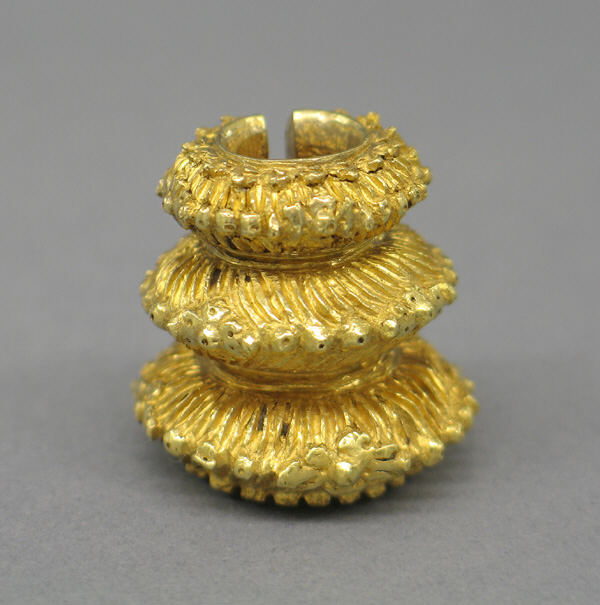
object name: fastener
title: Weighted Fastener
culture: indonesian, javanese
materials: gold